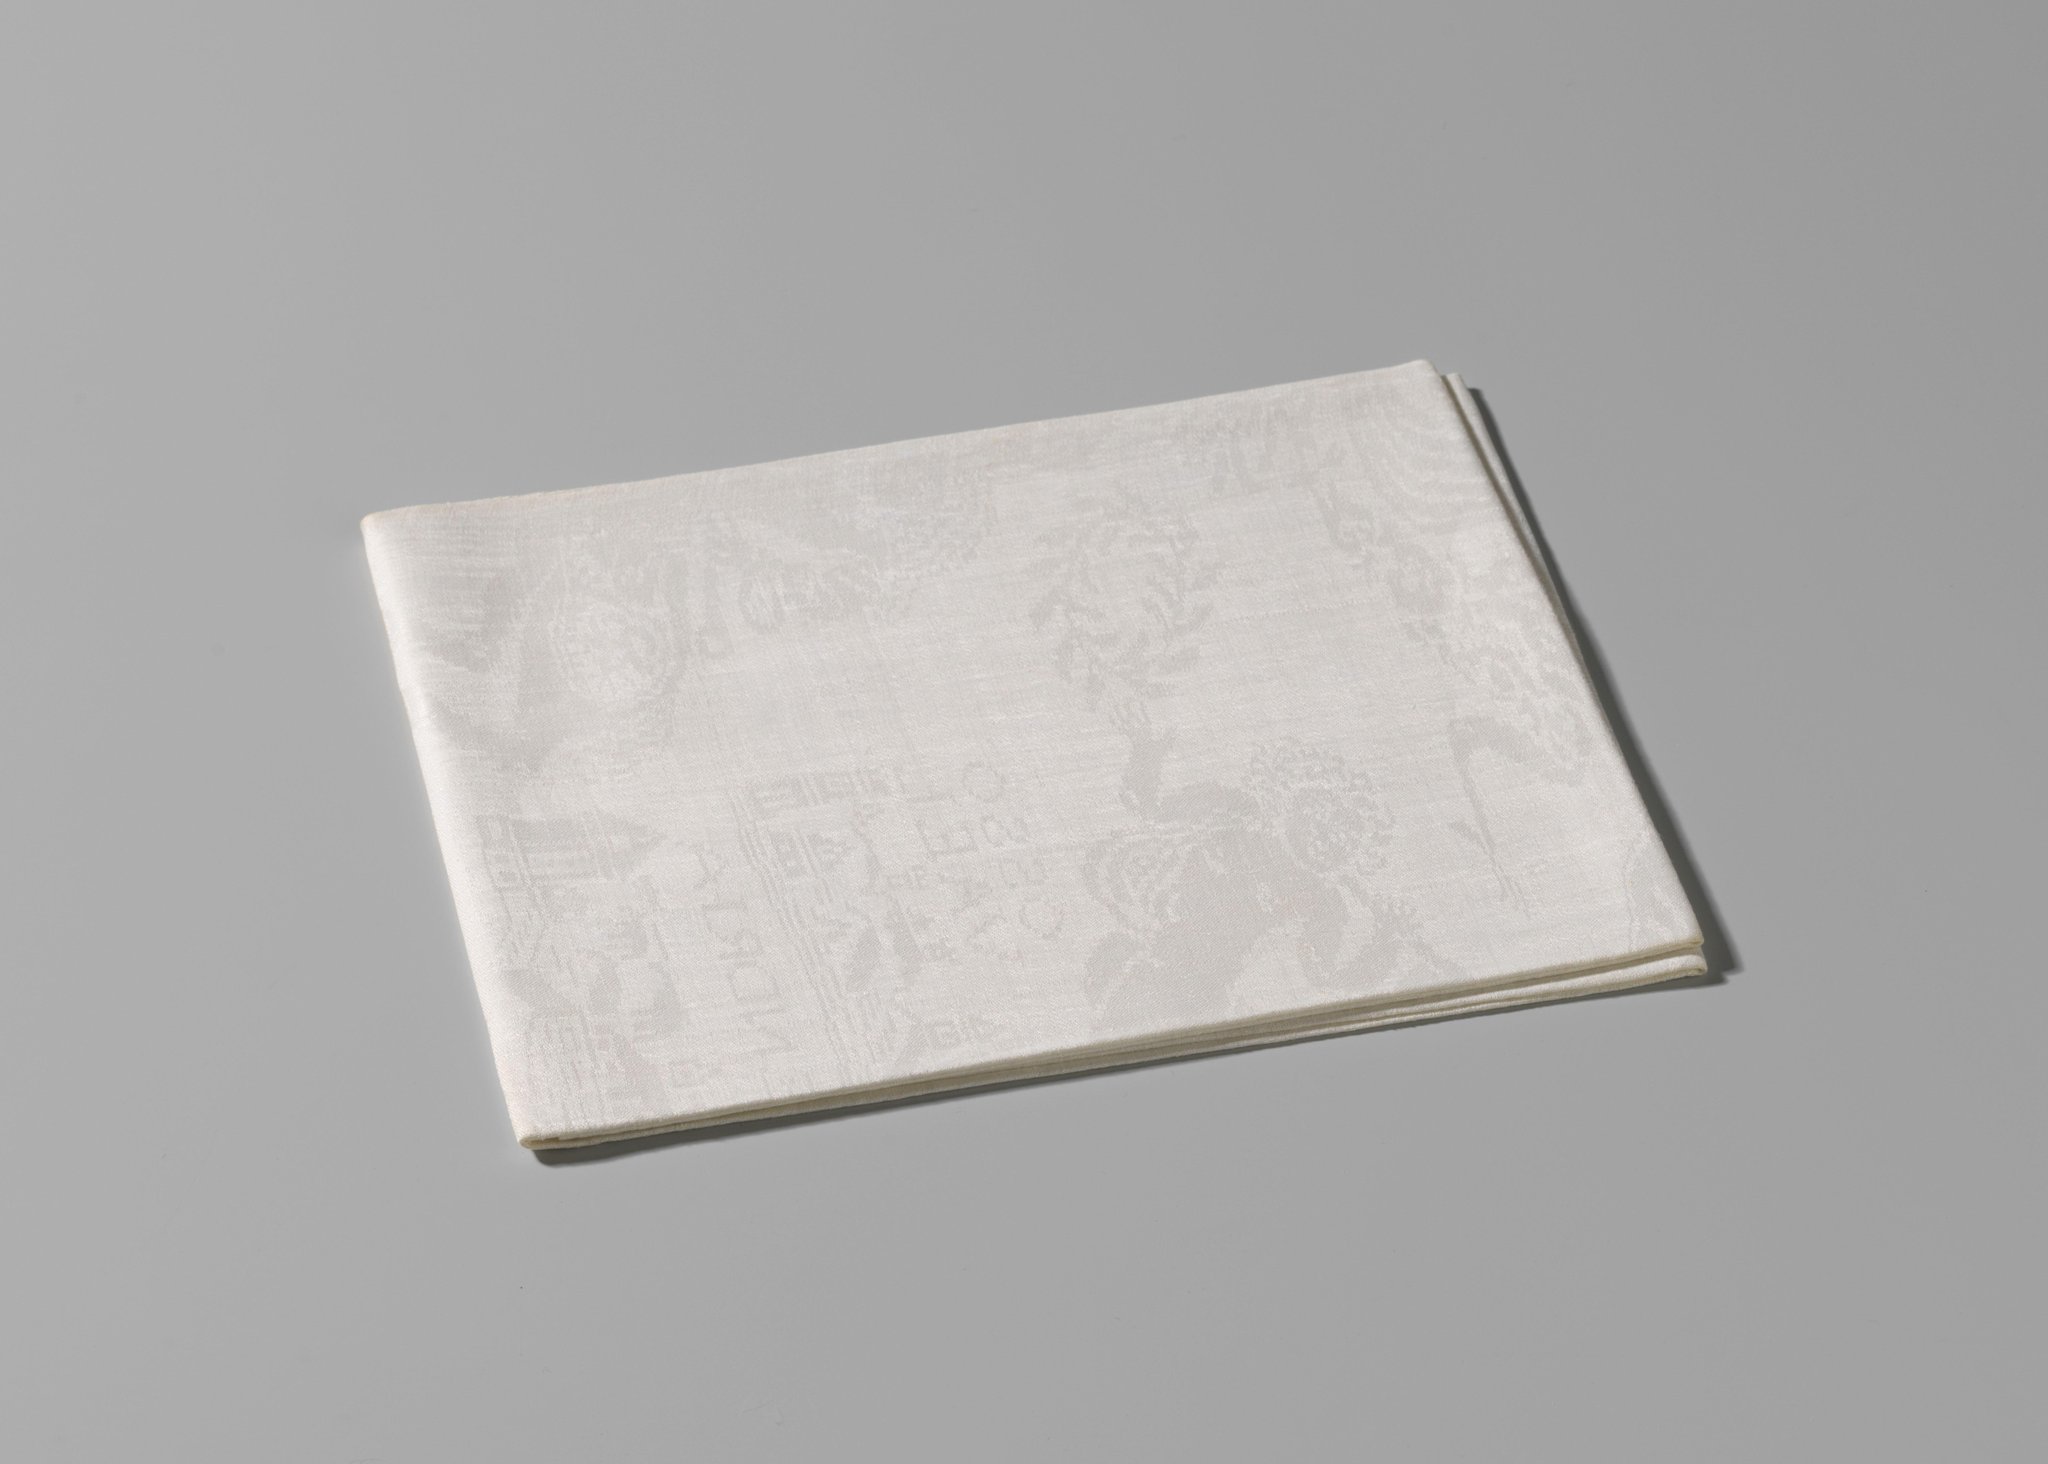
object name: napkin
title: Servet van wit linnendamast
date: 1717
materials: linen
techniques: damask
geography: flanders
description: Wit linnen damasten servet met de overwinningen op de Turken door Eugenius van Savoye onder Karel VI van Oostenrijk. Gemerkt T C 38.